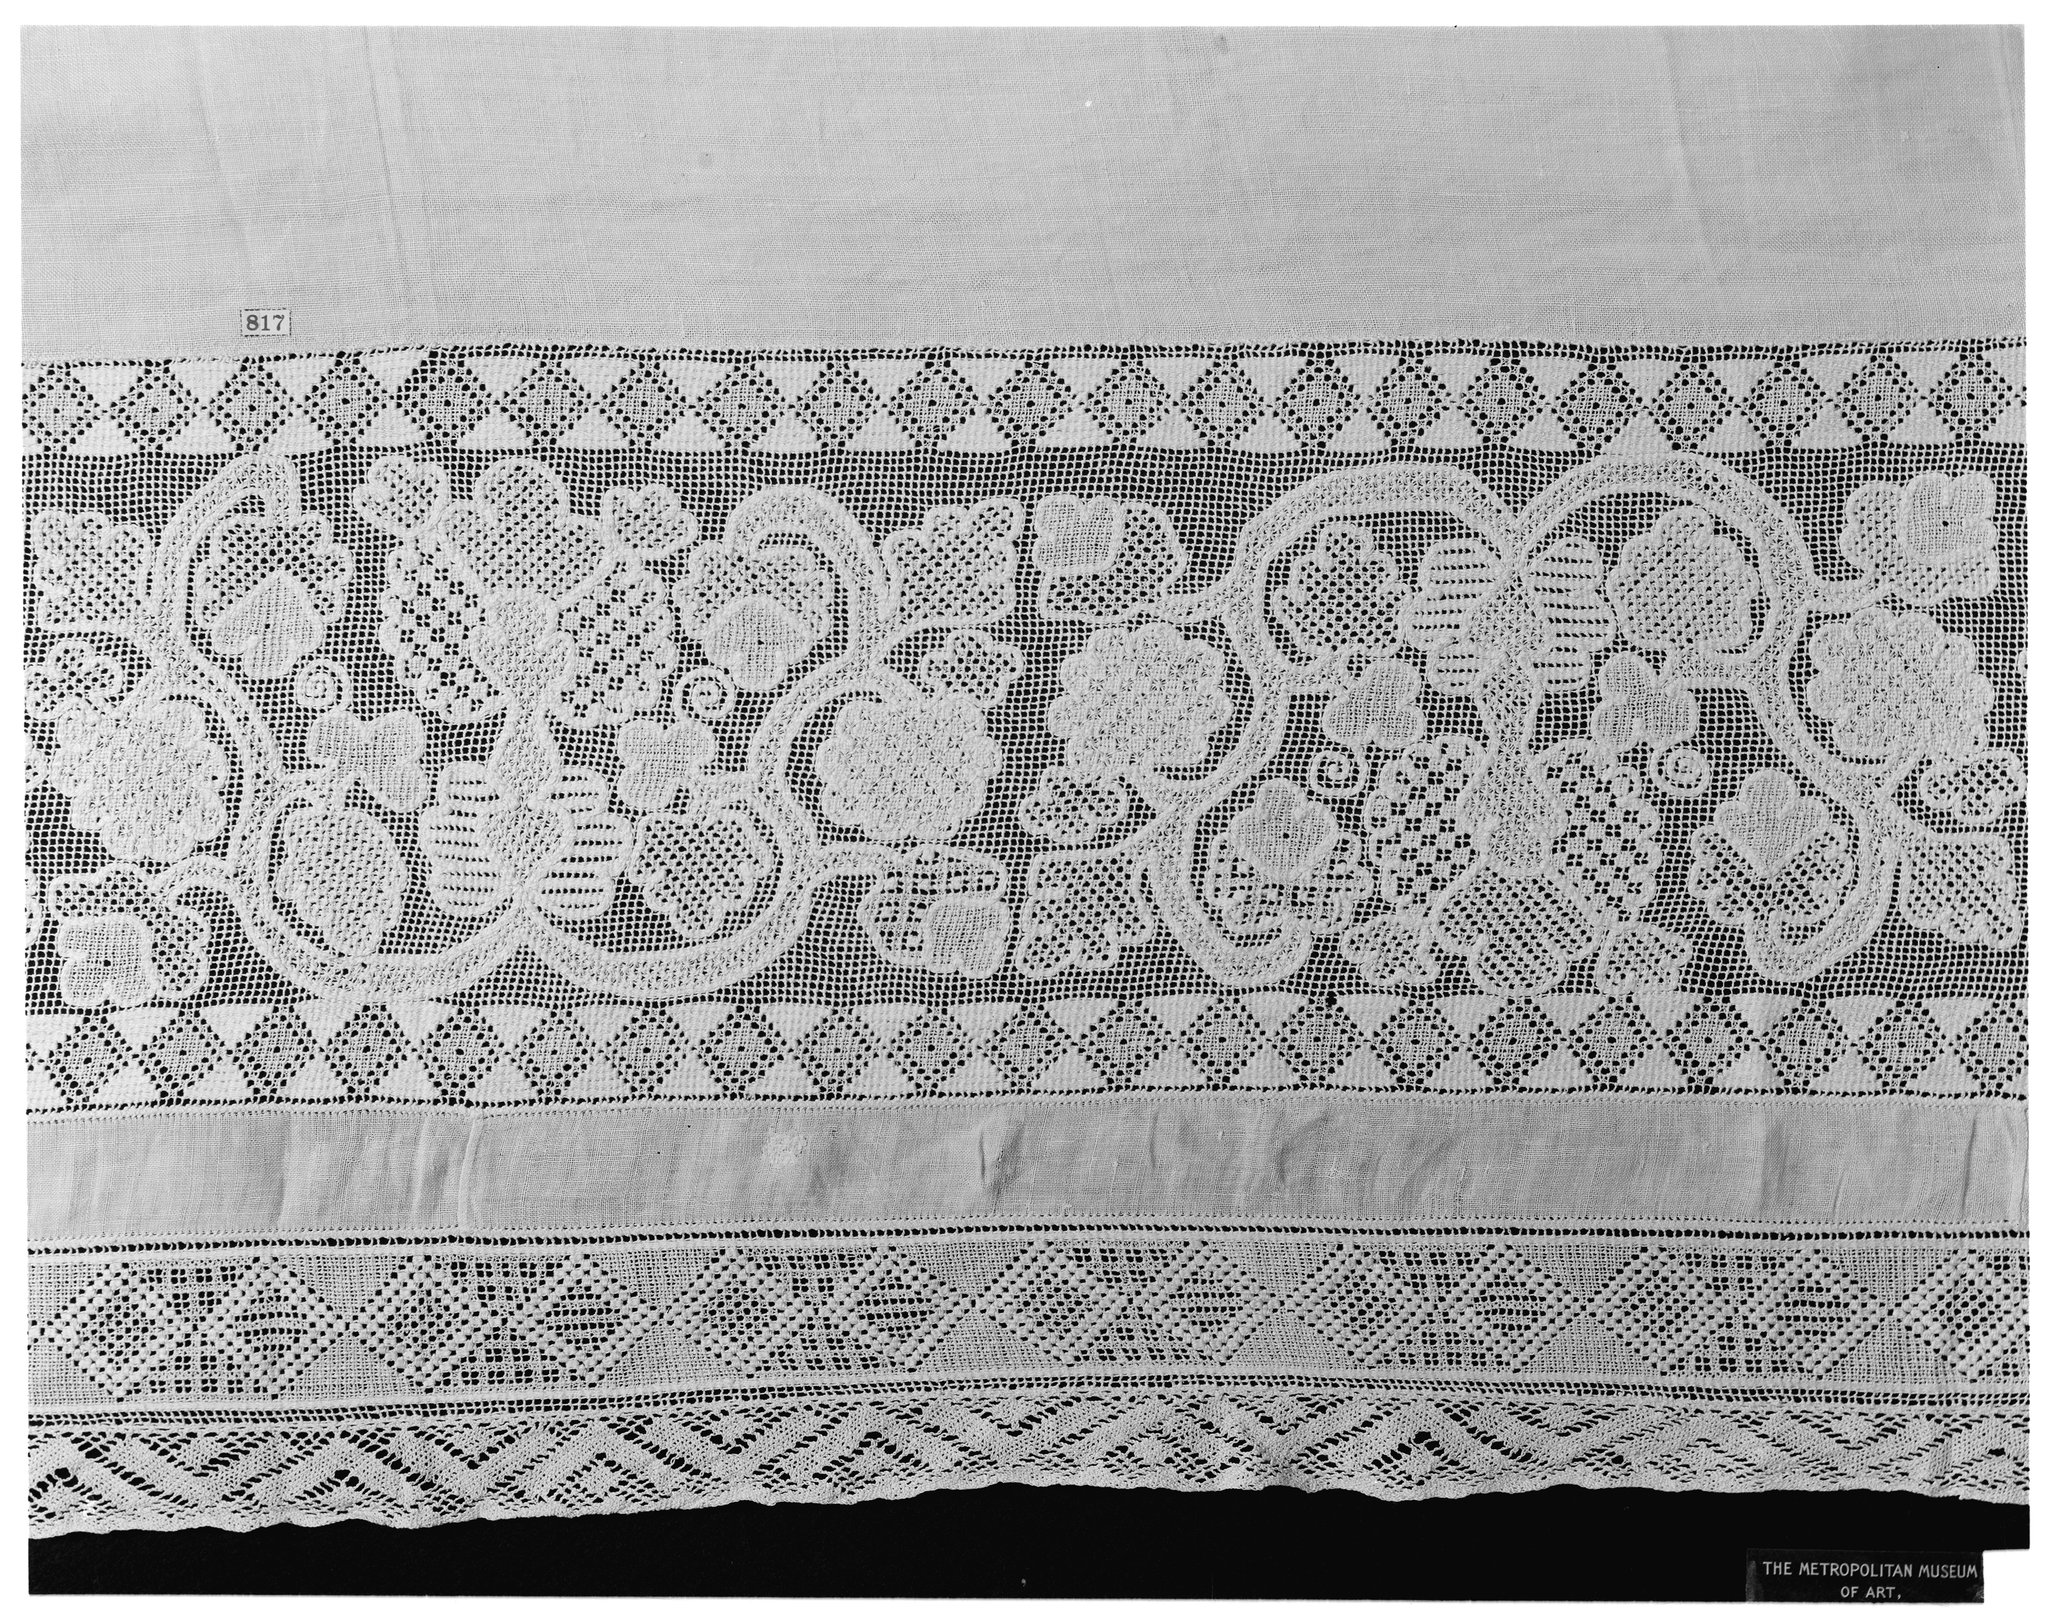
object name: border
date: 1701-1800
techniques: embroidery